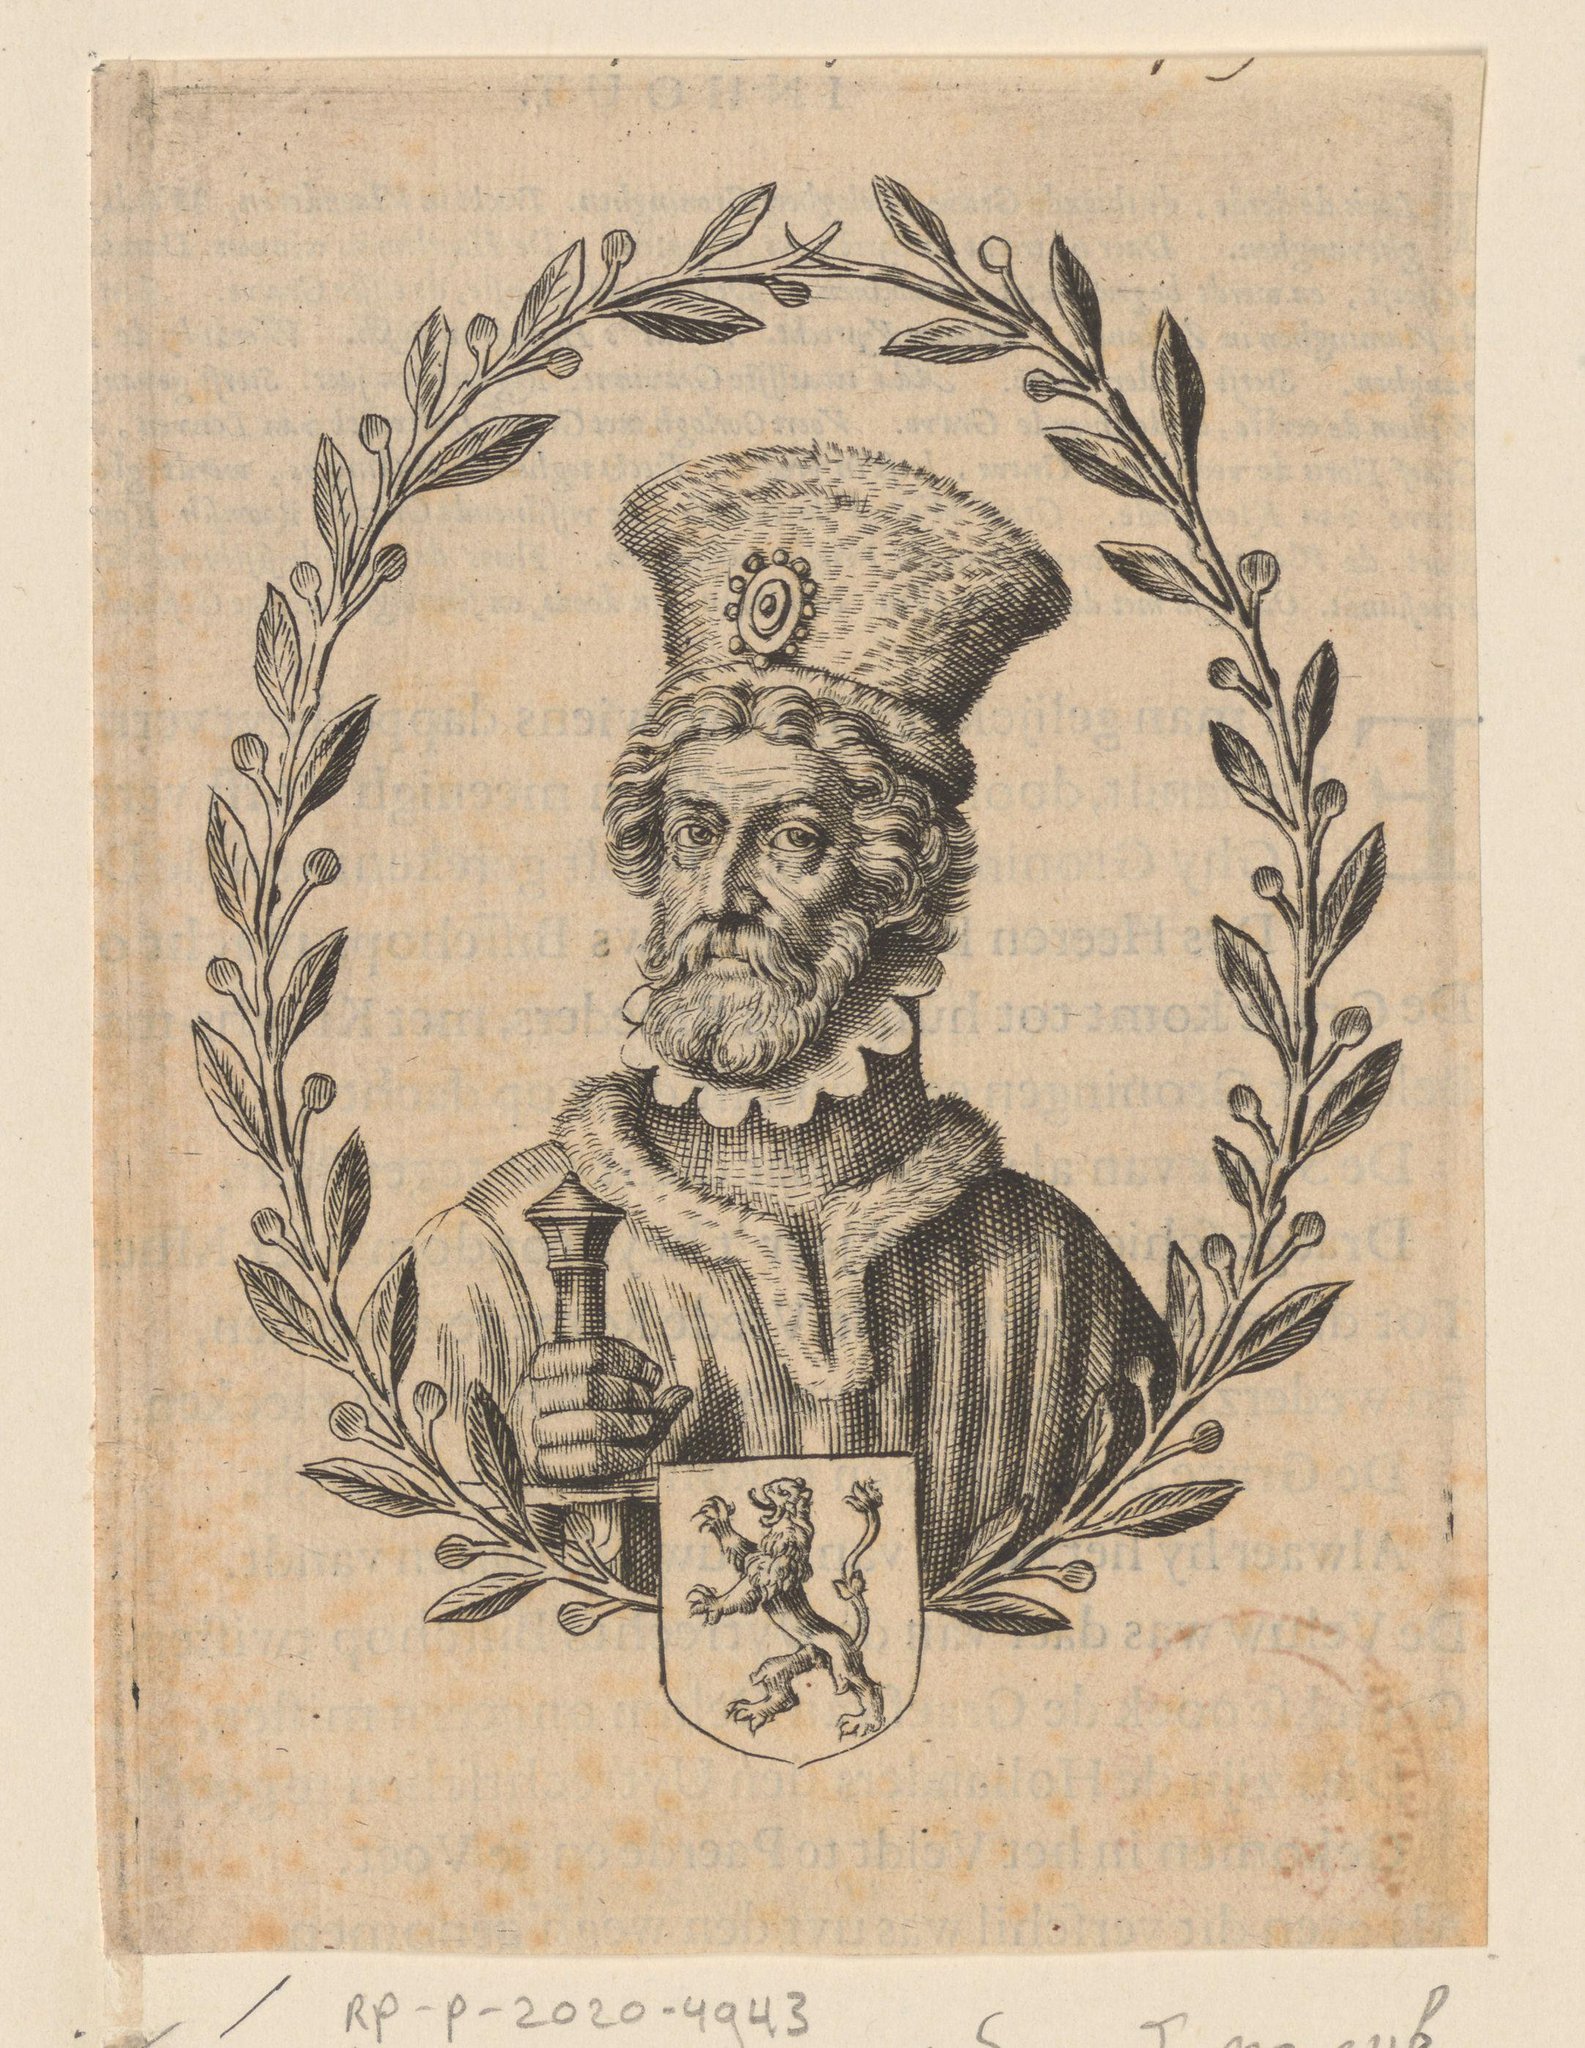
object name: book illustration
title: Portret van Floris III, graaf van Holland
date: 1645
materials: paper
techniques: engraving, letterpress printing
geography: amsterdam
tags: historical persons, hacking and thrusting weapons: sword, armorial bearing, heraldry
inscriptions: collector's mark: Lugt 240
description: Prent uit: Wachtendorp, Casparus. Oude Hollandsche Geschiedenissen ofte, corte Rym-Kronyck (...). Amsterdam: Johannes Pauli, 1645. Latere staat gebruikt in Scriverius' 'Hollandsche, Zeelandsche ende Vriesche Chronyck (...)', 1678.